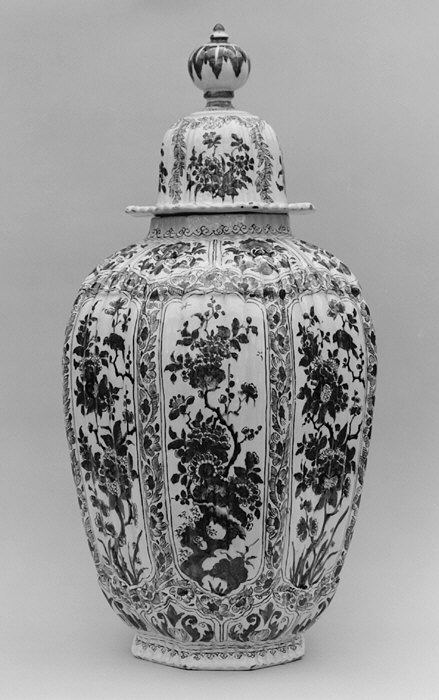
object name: vase with cover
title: Vase with cover (one of a pair)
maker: lambertus van eenhoorn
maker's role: artist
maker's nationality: dutch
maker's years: 1651-1721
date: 1700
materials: earthenware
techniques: glazing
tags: flowers